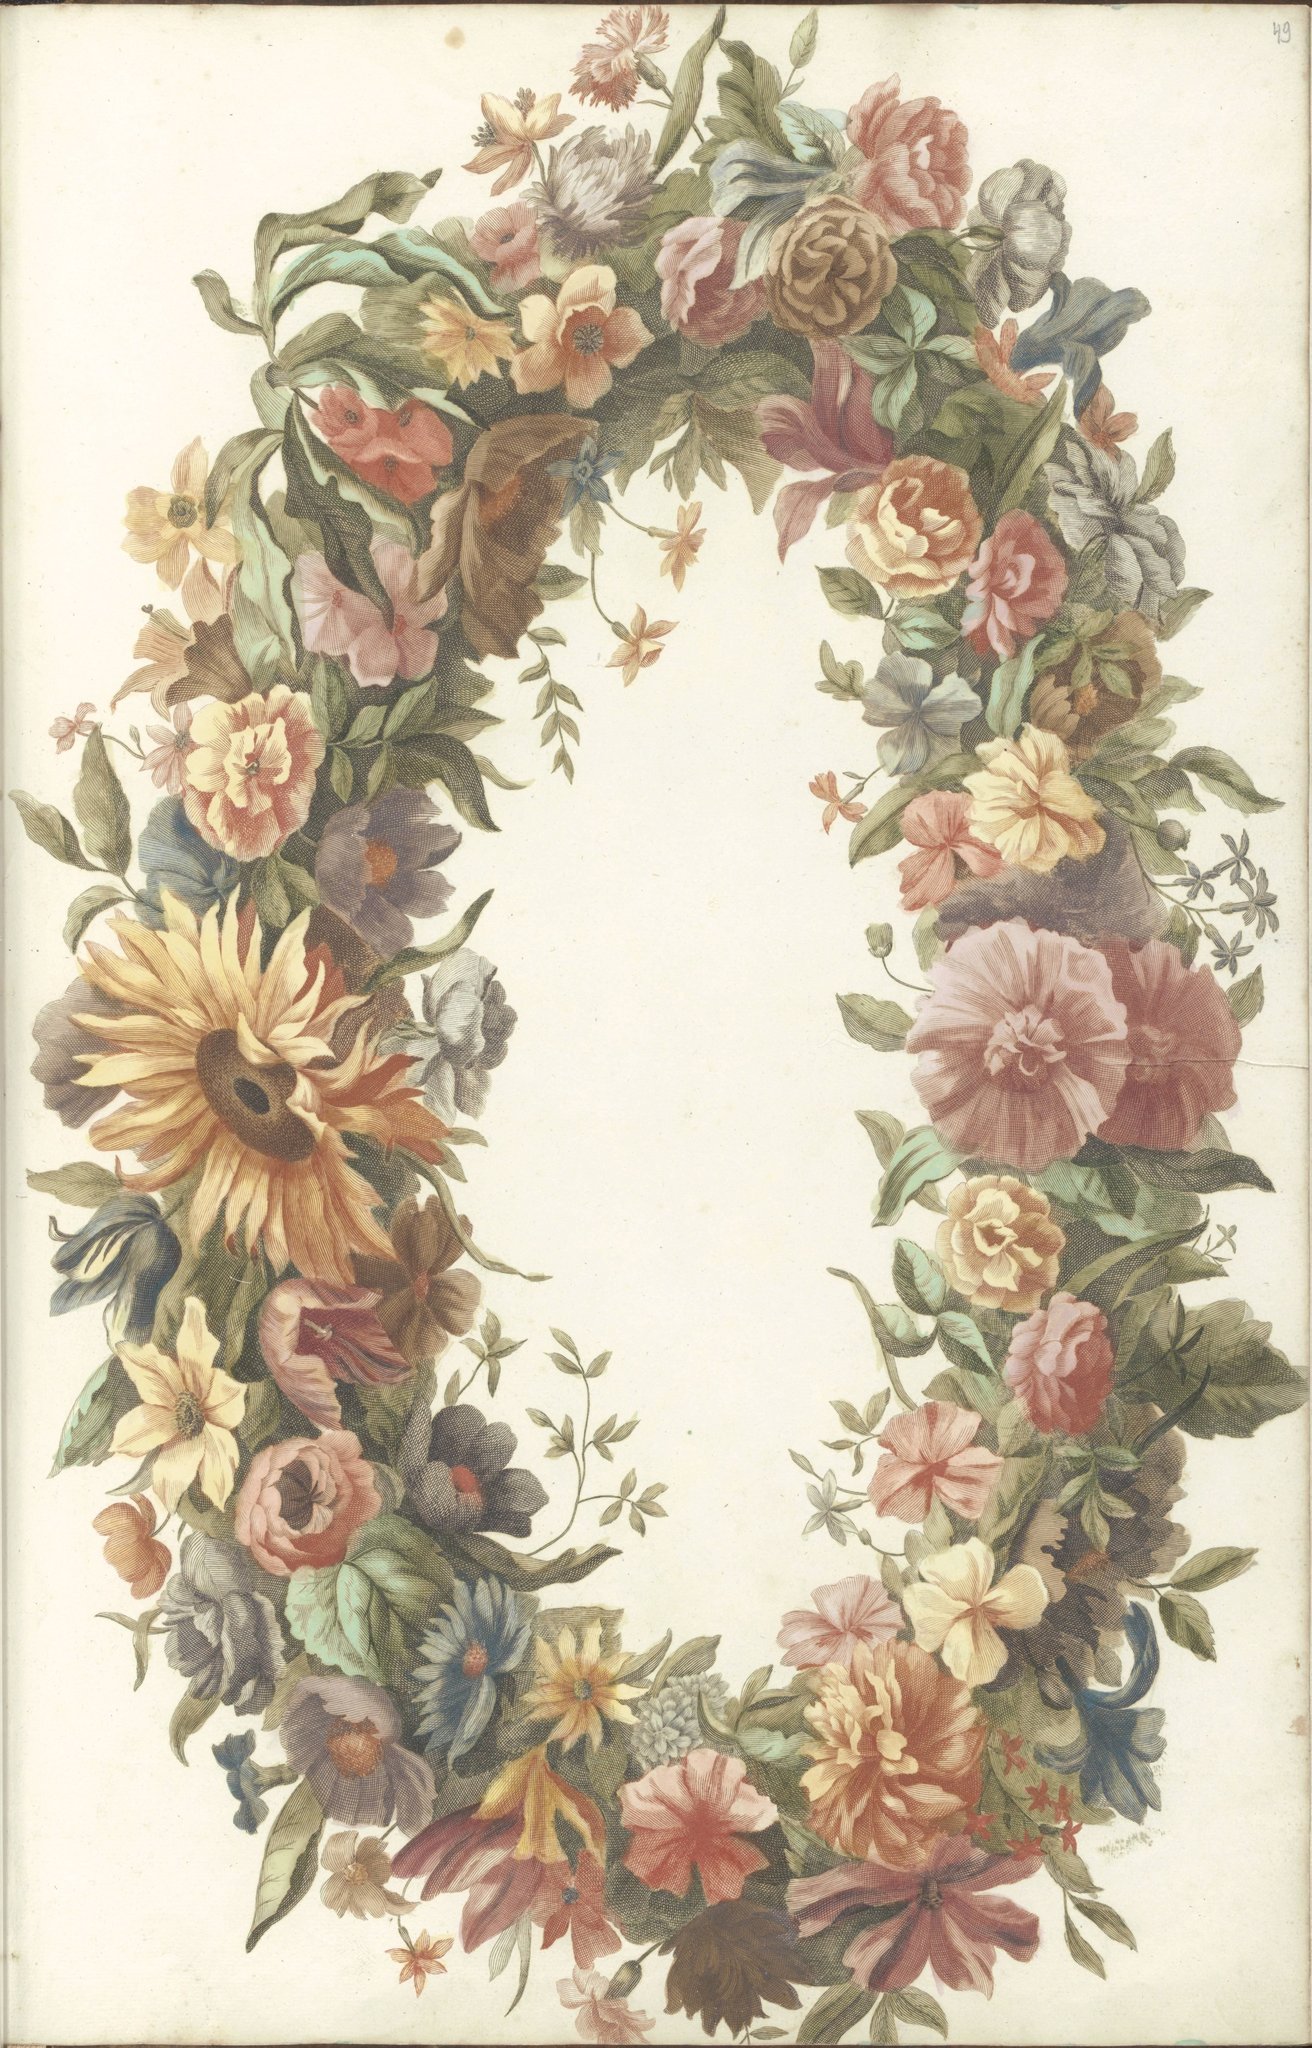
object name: album leaf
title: Ovale bloemenkrans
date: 1688-1698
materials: paper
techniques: printing, engraving, hand coloring, lithography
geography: netherlands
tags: garland, wreath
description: Deze prent maakt deel uit van een album.